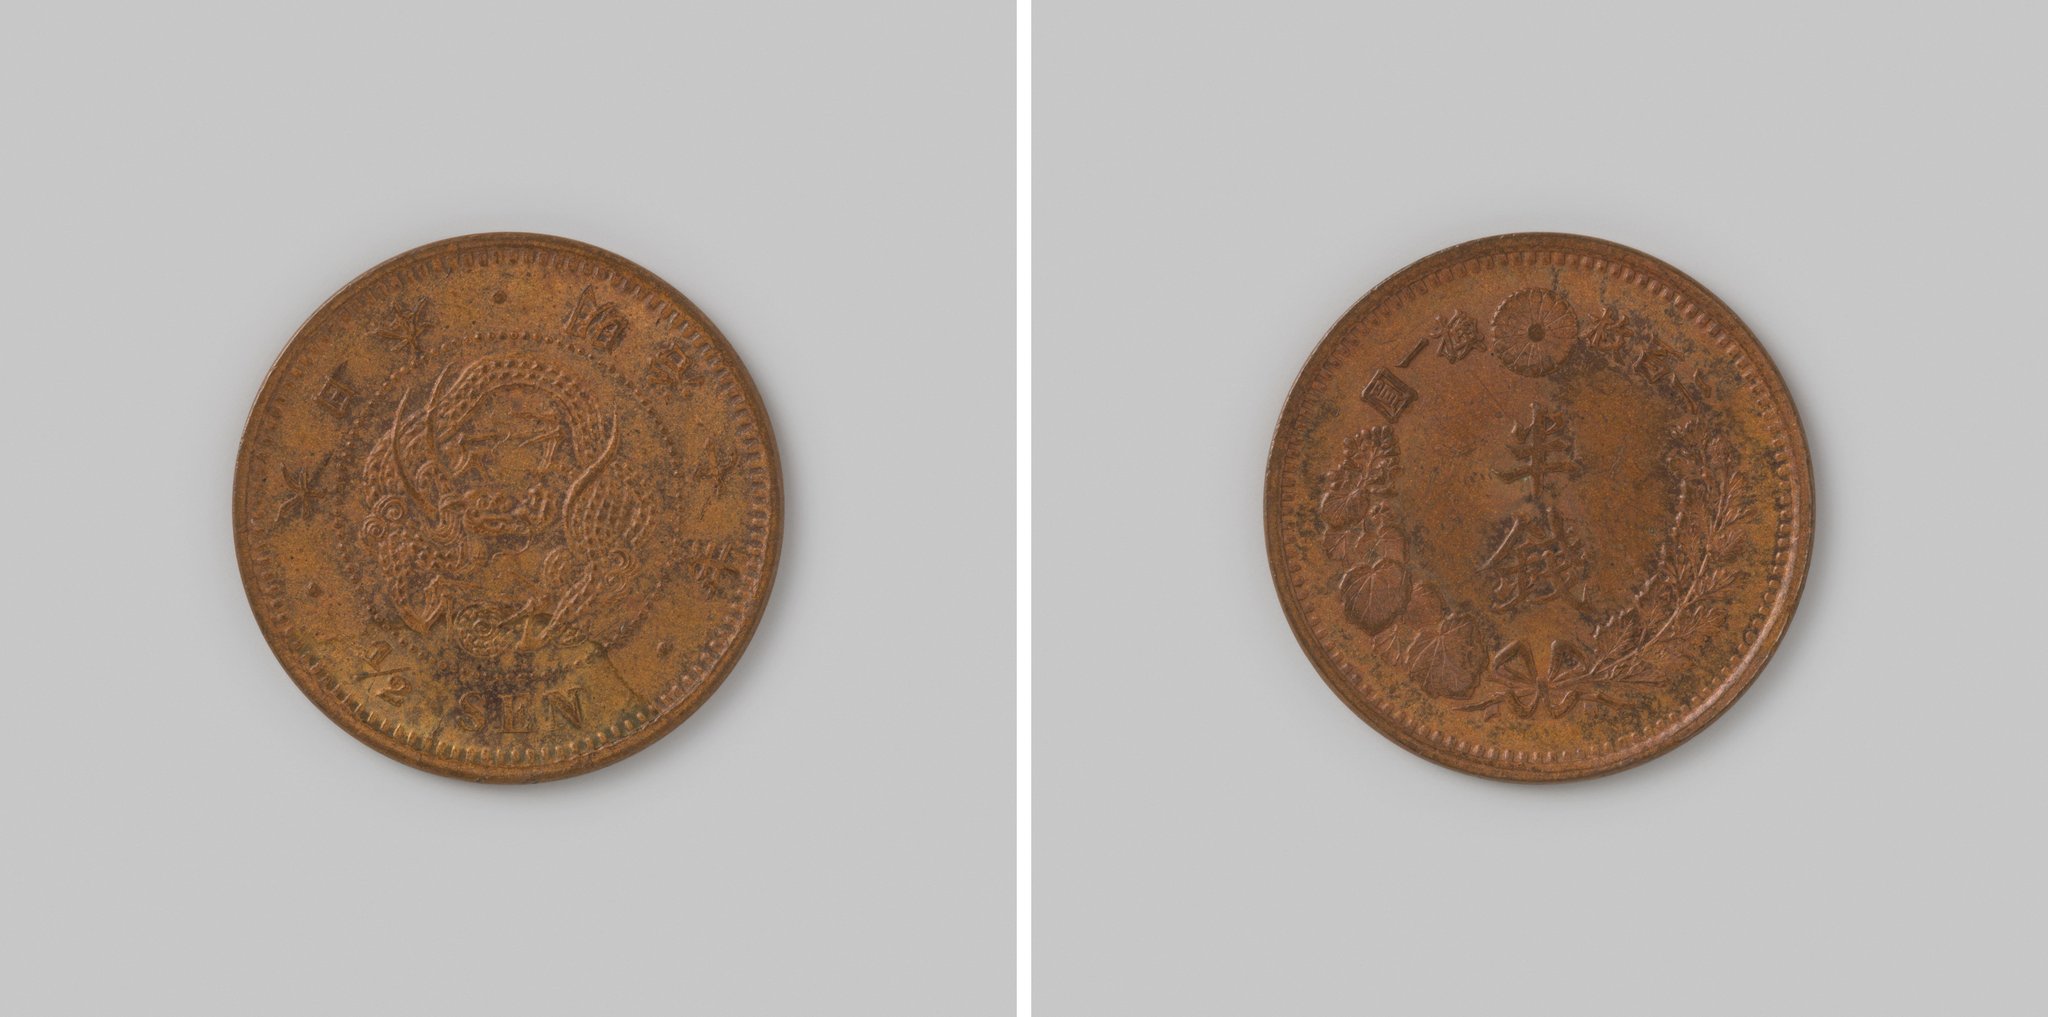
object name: coin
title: Keizerrijk Japan, Meiji tijdperk, ½ sen, regeringsjaar 7 [=1874]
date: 1874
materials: copper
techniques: striking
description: Koperen munt. Voorzijde: binnen cirkel gestileerde draak met in omschrift onderaan waarde-aanduiding. Keerzijde: binnen twee samengebonden takken, waarboven een symbool, op twee regels onder elkaar waarde-aanduiding. Gladde rand.